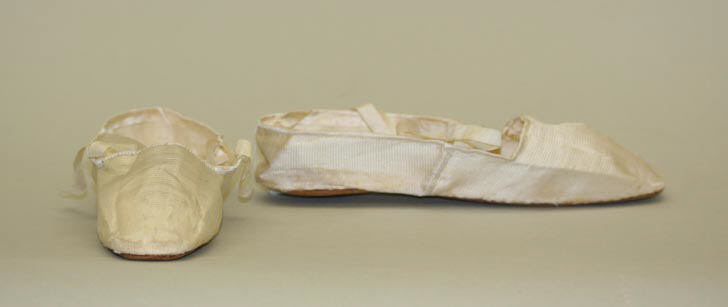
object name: shoe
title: Shoes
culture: american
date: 1815-1817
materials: silk